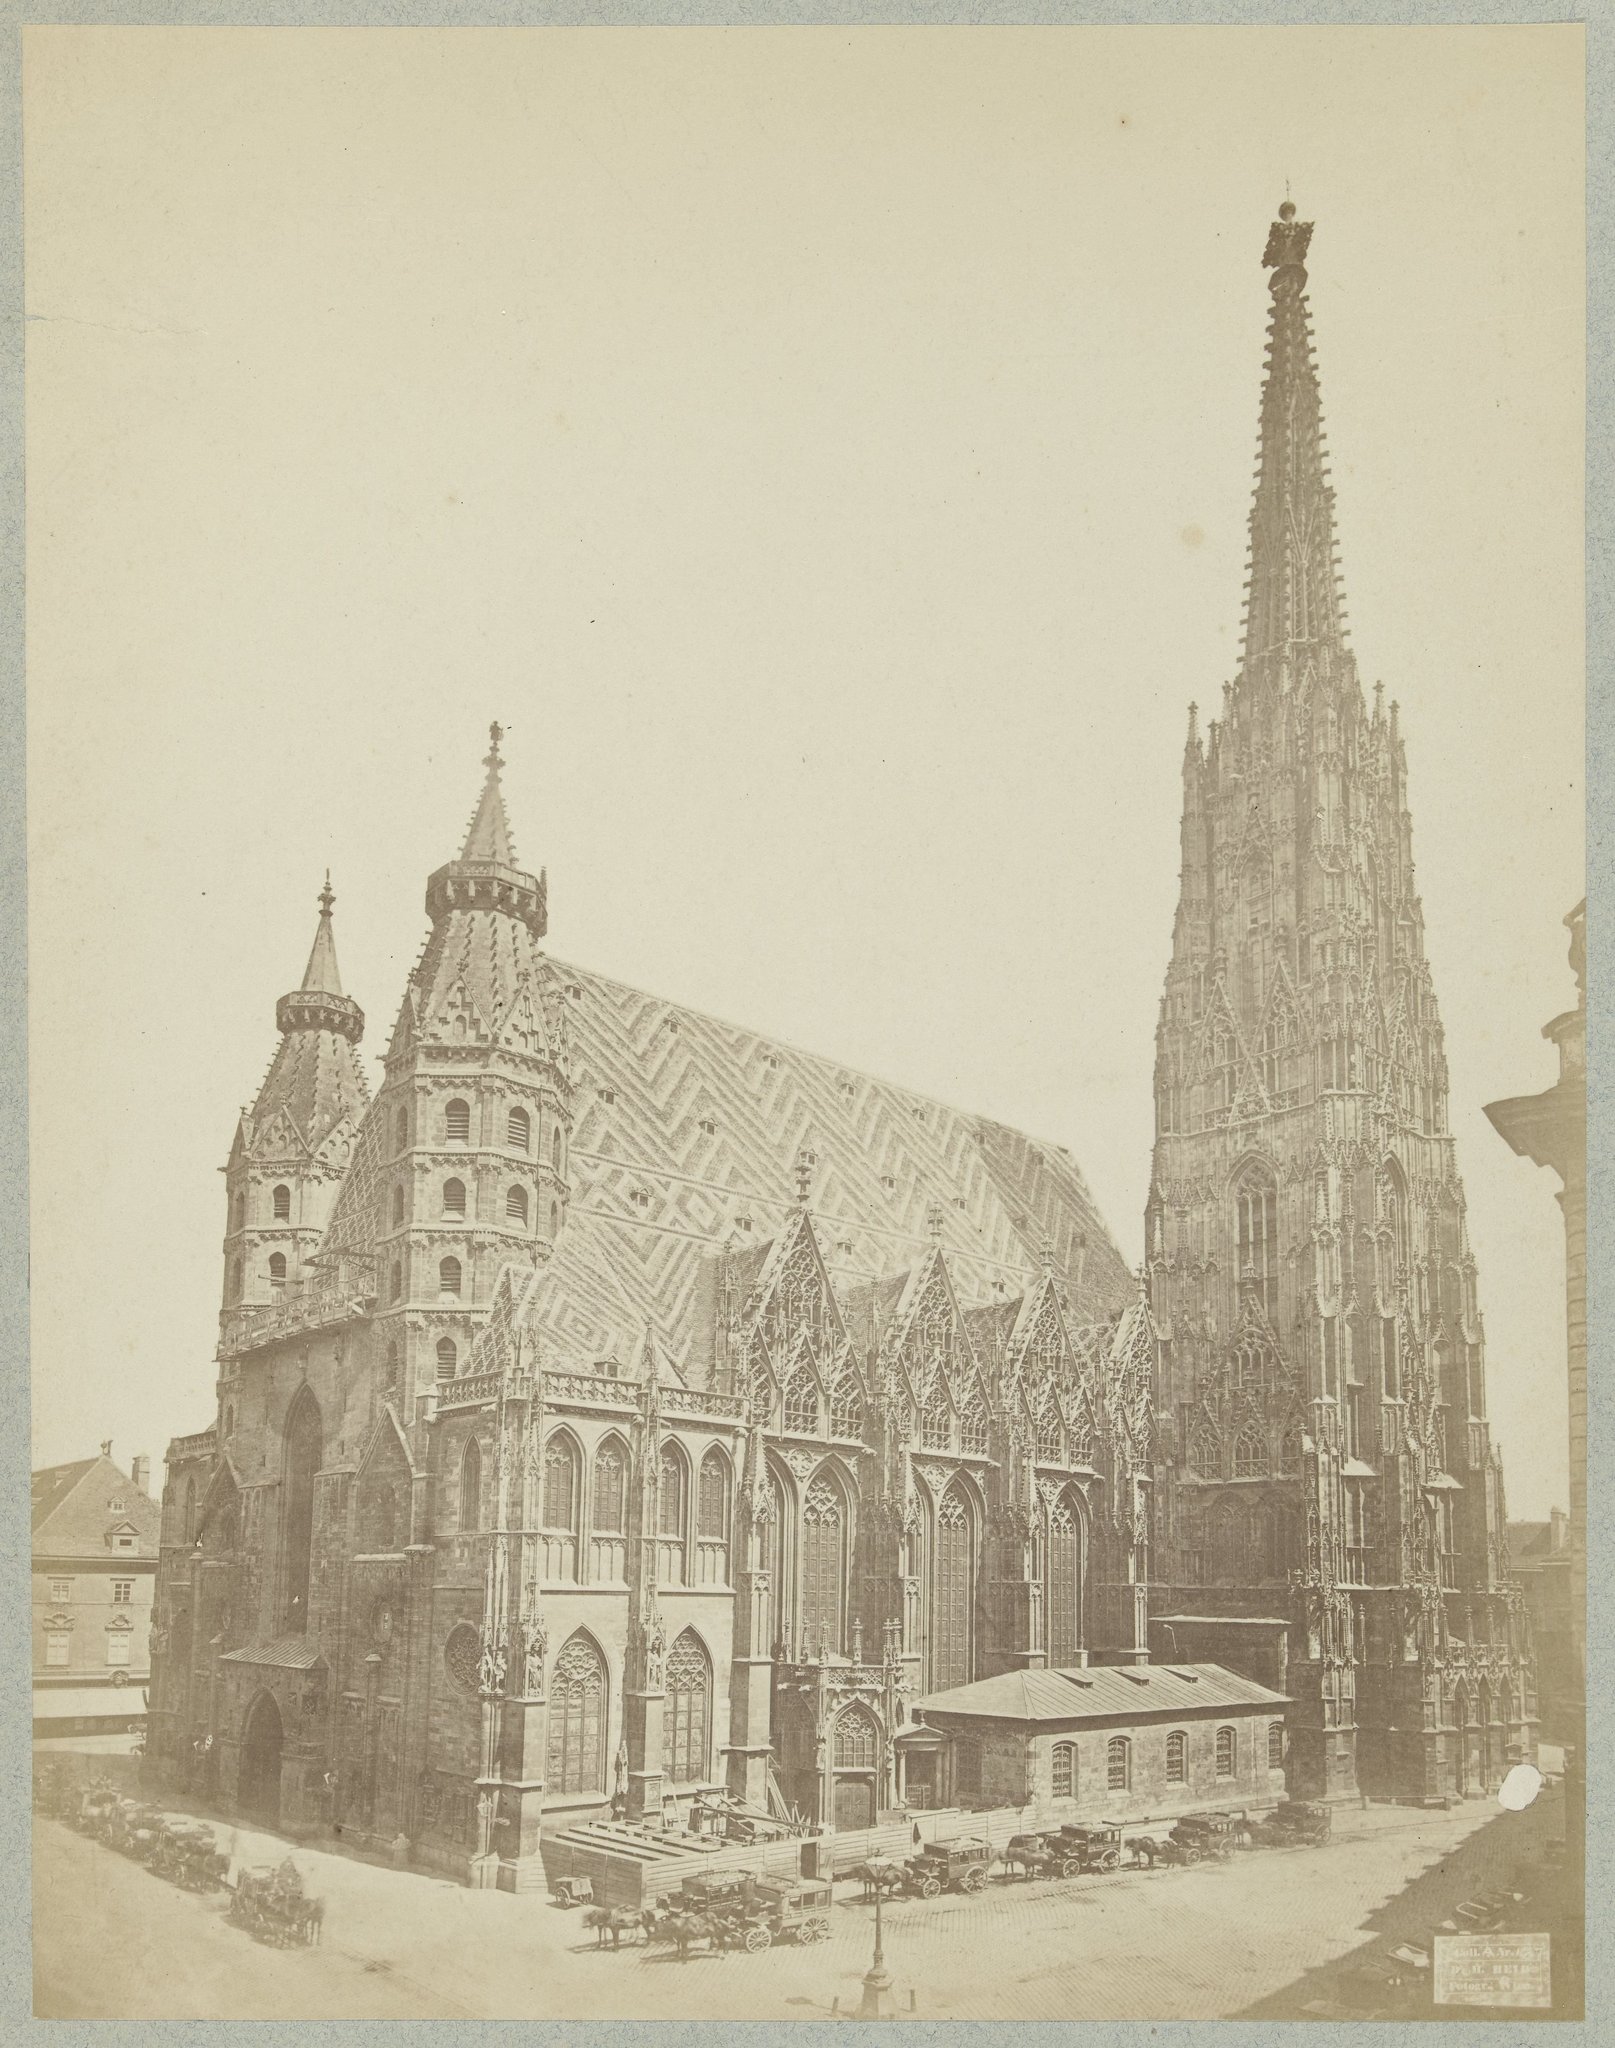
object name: photograph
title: St. Stephan Dom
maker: hermann heid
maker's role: fotograaf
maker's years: 1834-1891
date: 1865-1891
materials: cardboard, paper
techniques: albumen print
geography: vienna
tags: church (exterior)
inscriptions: number: ‘Nr. 137’